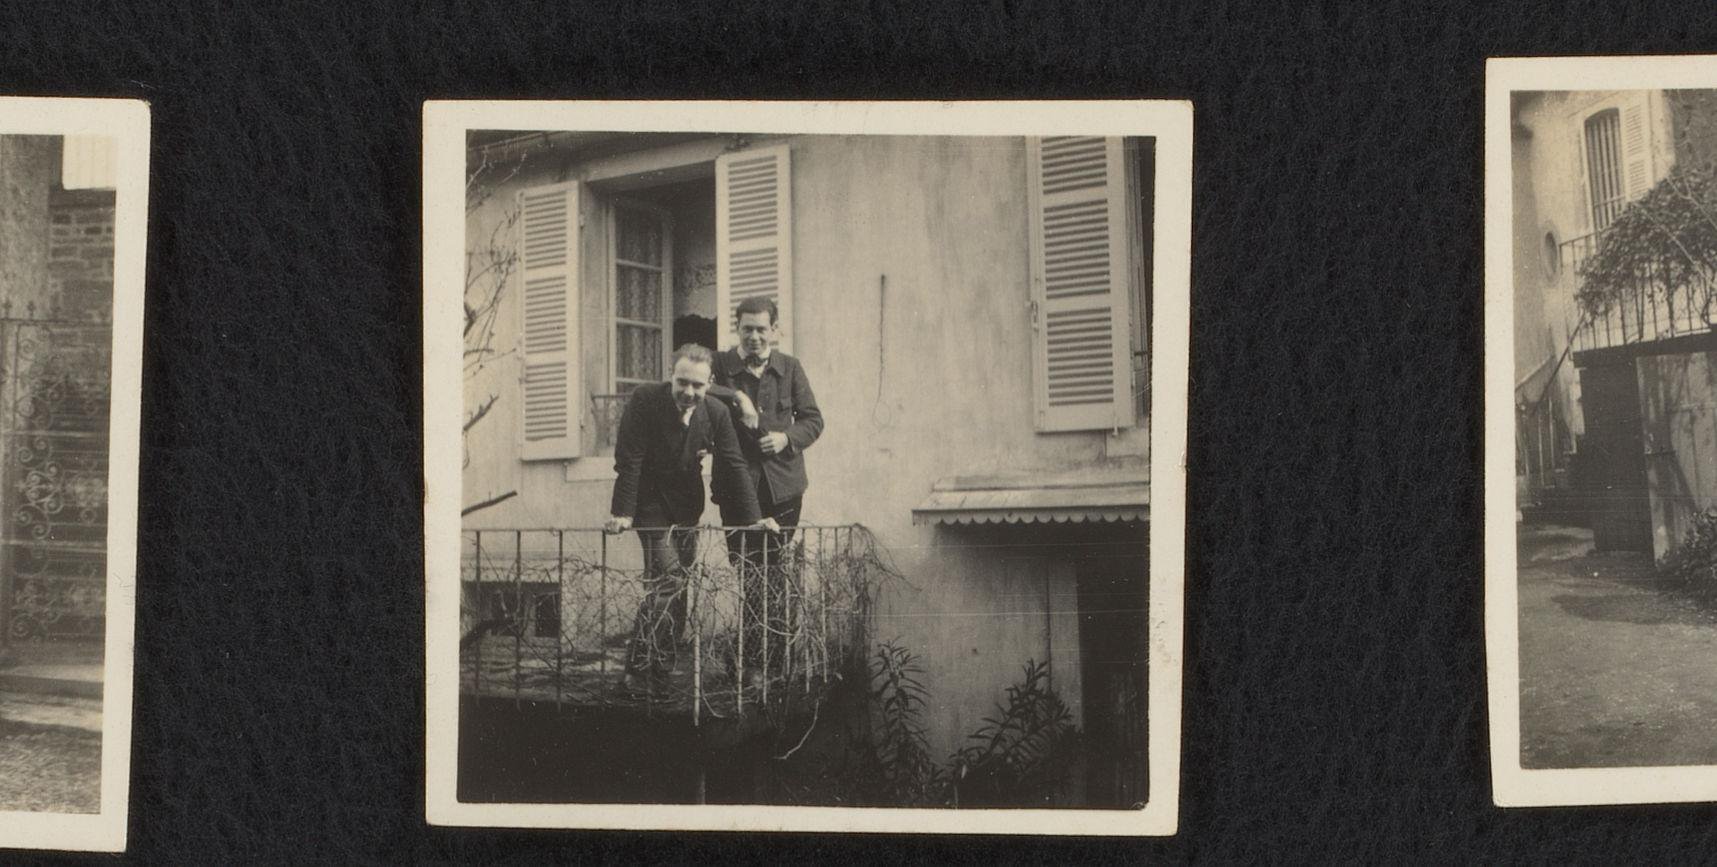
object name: photograph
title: Twee mannen voor een huis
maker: Anonymous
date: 1930-1950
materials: photographic support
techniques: gelatin silver print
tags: historical persons not known by name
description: Twee mannen, waaronder Koenen, staande voor een huis. In envelop met losse foto's behorend bij het fotoalbum over de bewoners van het huis aan de Reguliersgracht te Amsterdam in de periode 1924-1932.